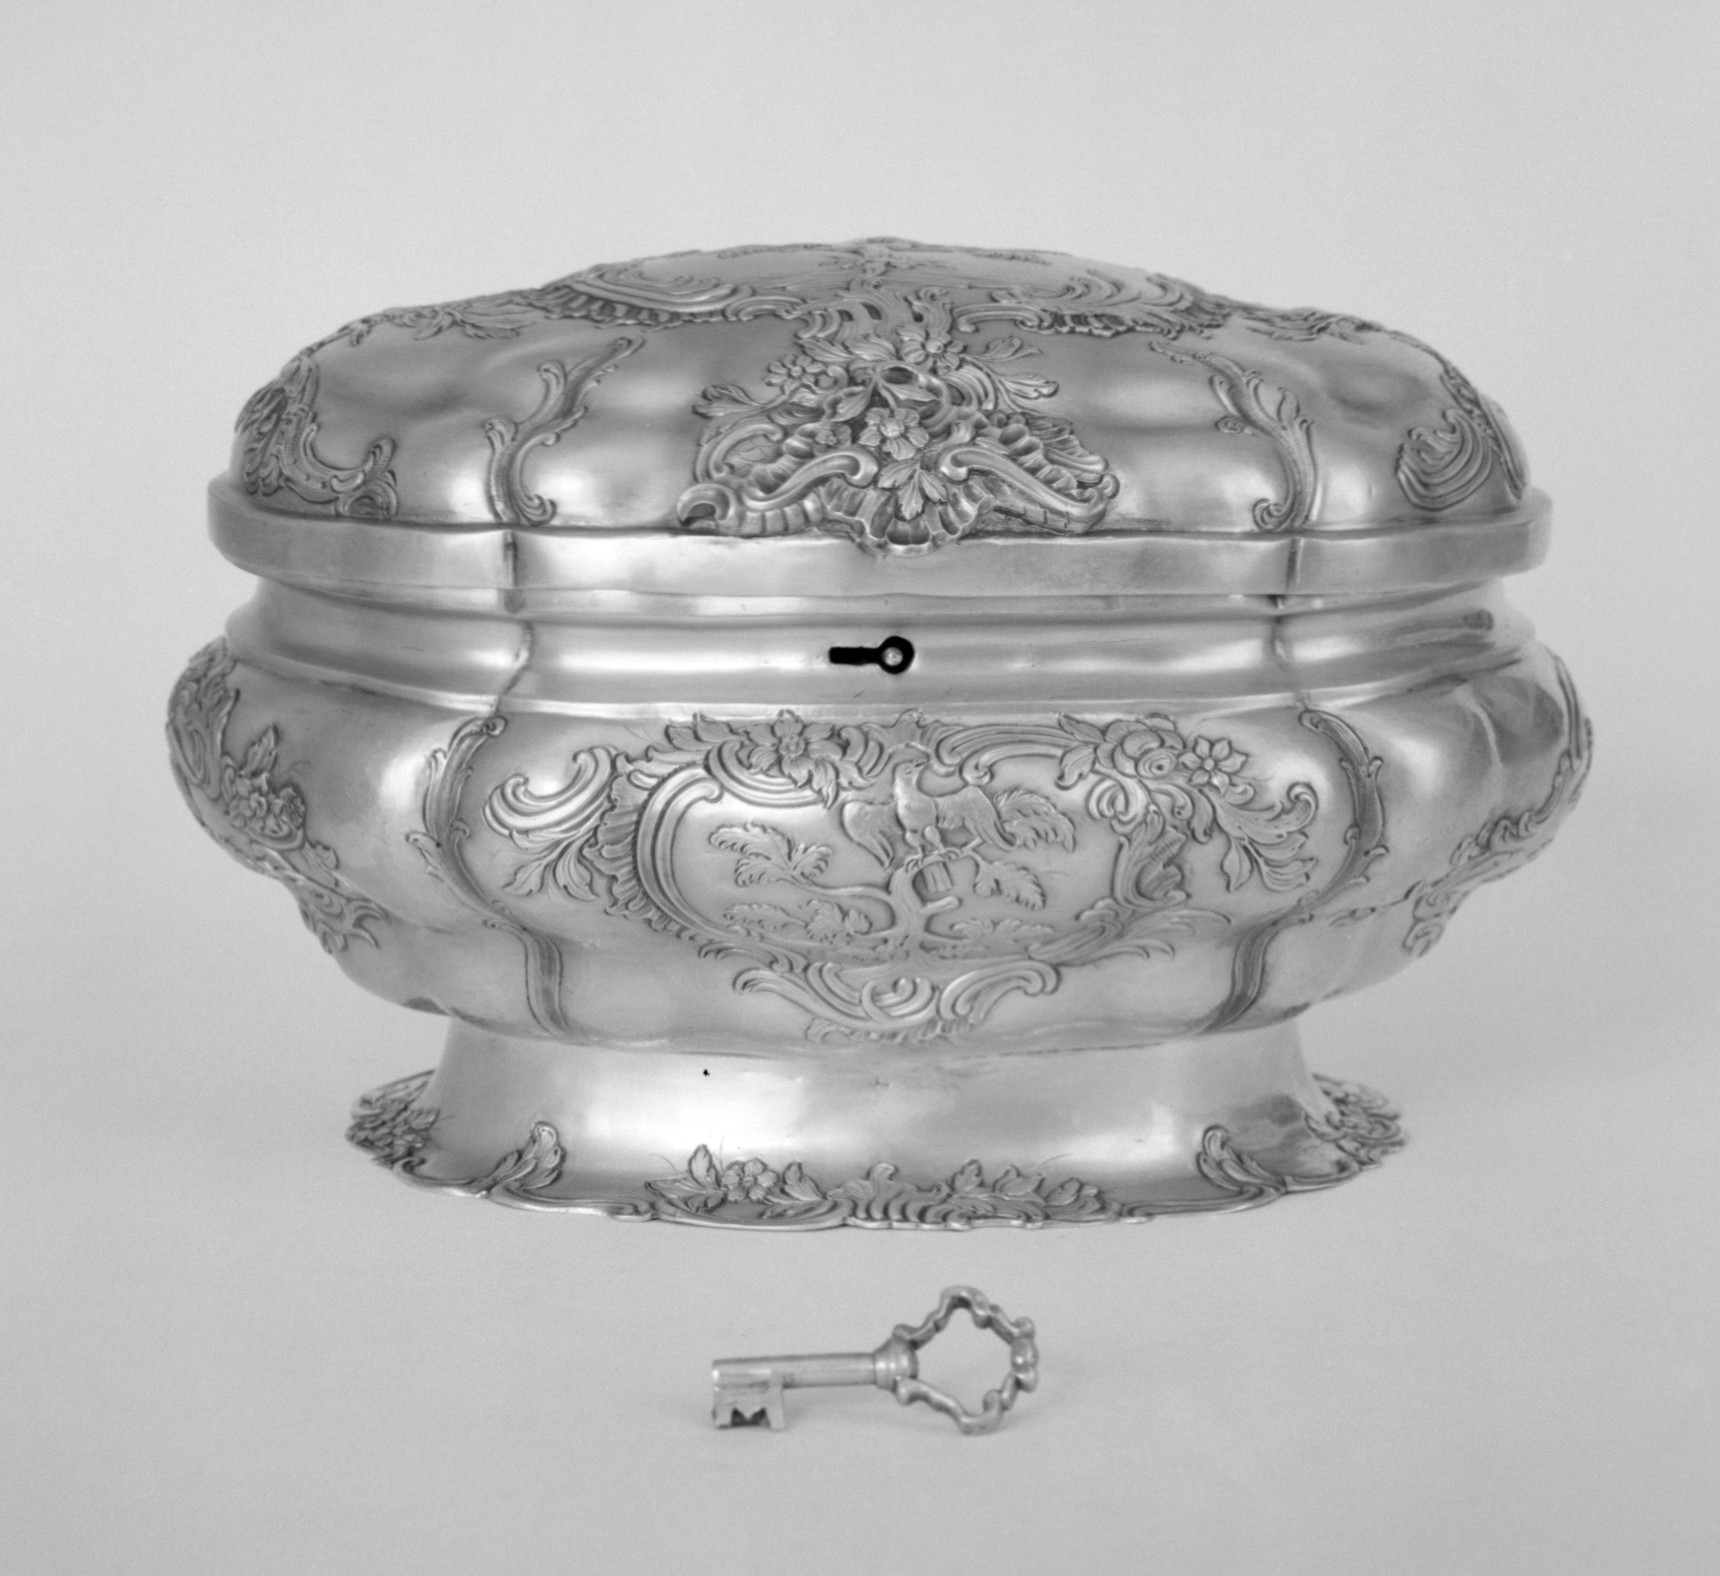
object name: box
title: Large oval box (one of a pair)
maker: gottlieb satzger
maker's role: maker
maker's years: 1709-1783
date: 1775-1777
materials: silver gilt